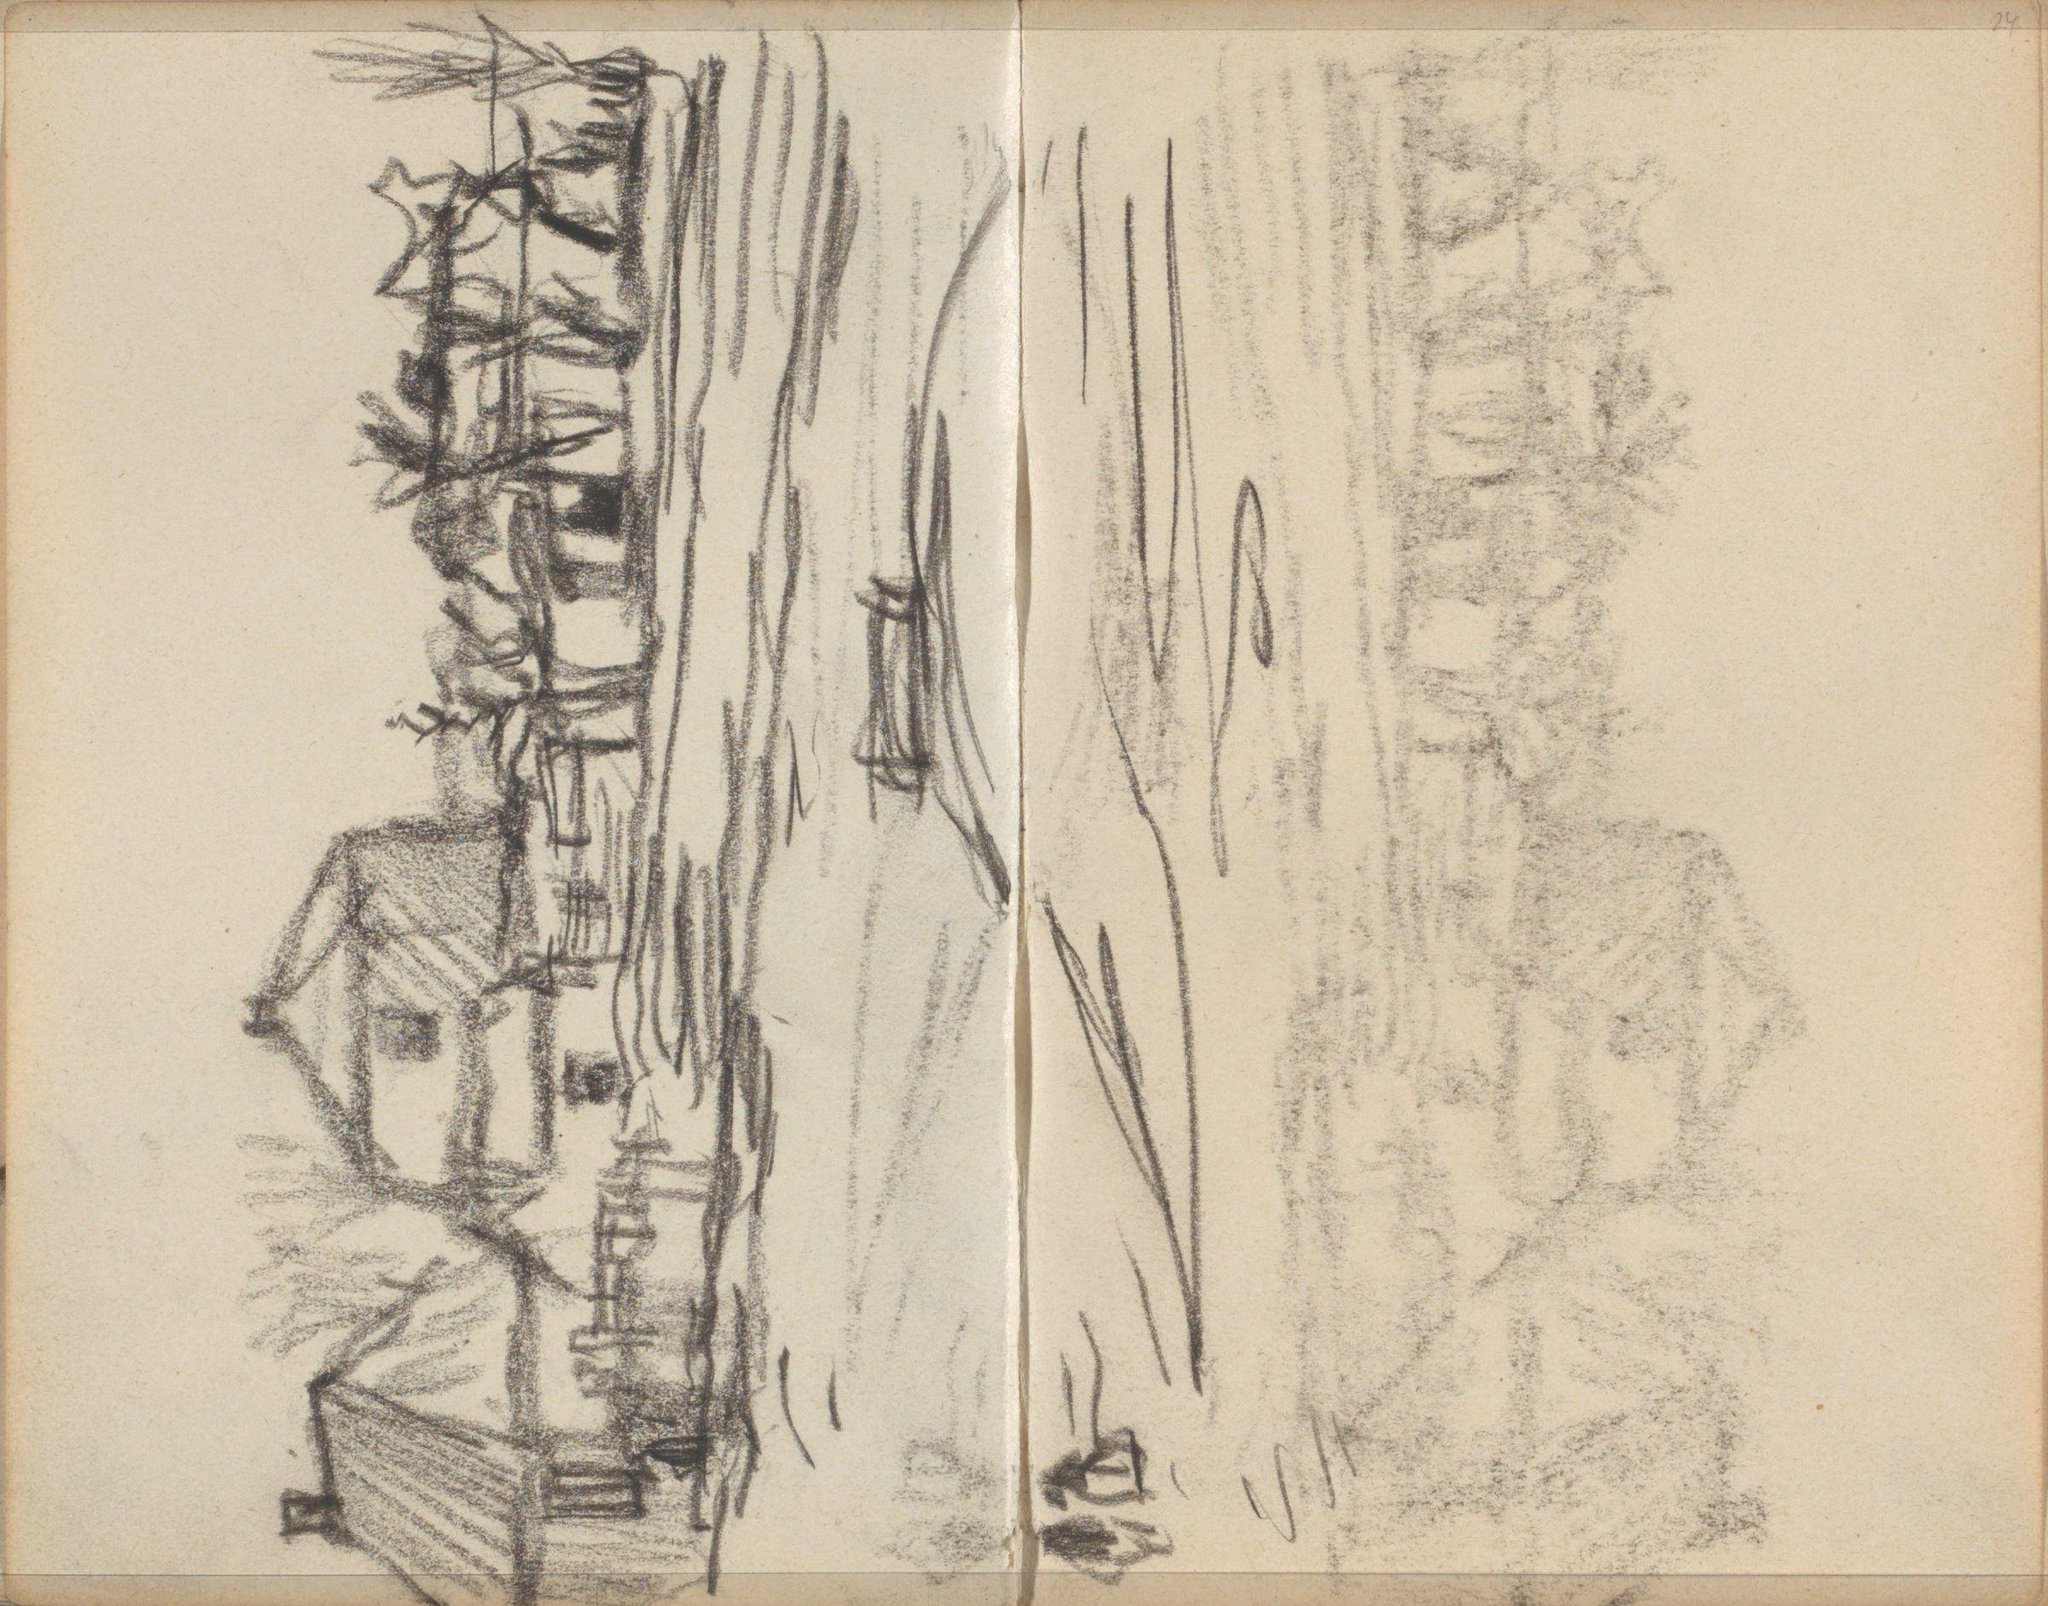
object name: sketchbook leaf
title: Landschap met bebouwing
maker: george hendrik breitner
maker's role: draughtsman, painter, print maker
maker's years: 1857-1923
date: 1910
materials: chalk, paper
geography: north holland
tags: landscapes, rural housing, e.g. country-house, villa, cottage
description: Pagina 23 en pagina 24 uit een schetsboek met 45 bladen.